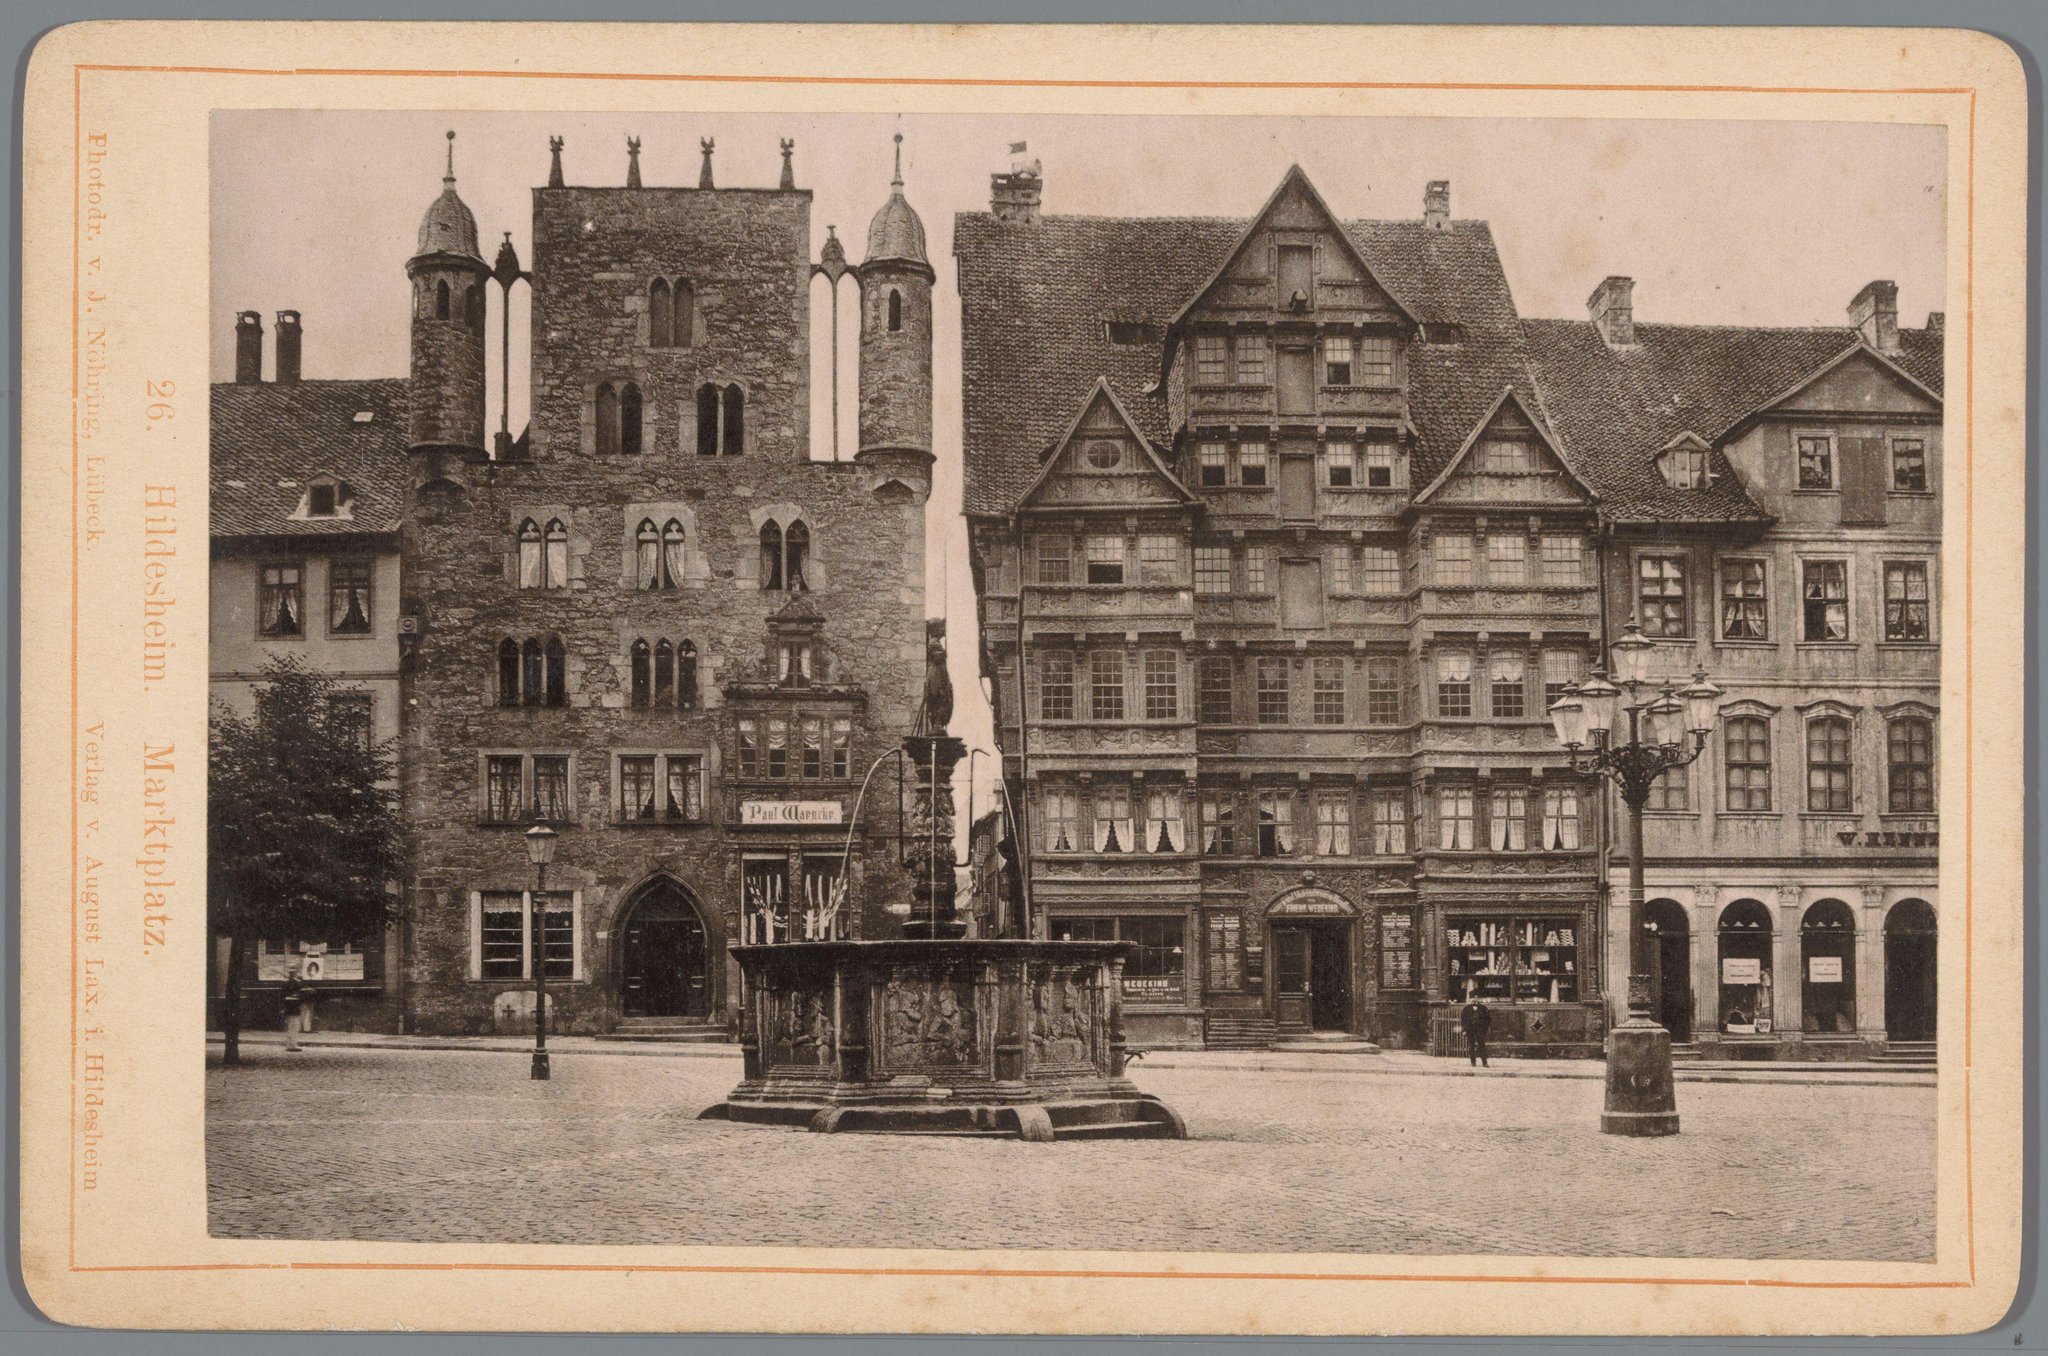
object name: photomechanical print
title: Hildesheim. Marktplatz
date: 1870-1900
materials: cardboard, paper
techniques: photograph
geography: lübeck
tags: square, place, circus, etc., ornamental fountain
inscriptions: number: ‘26.’